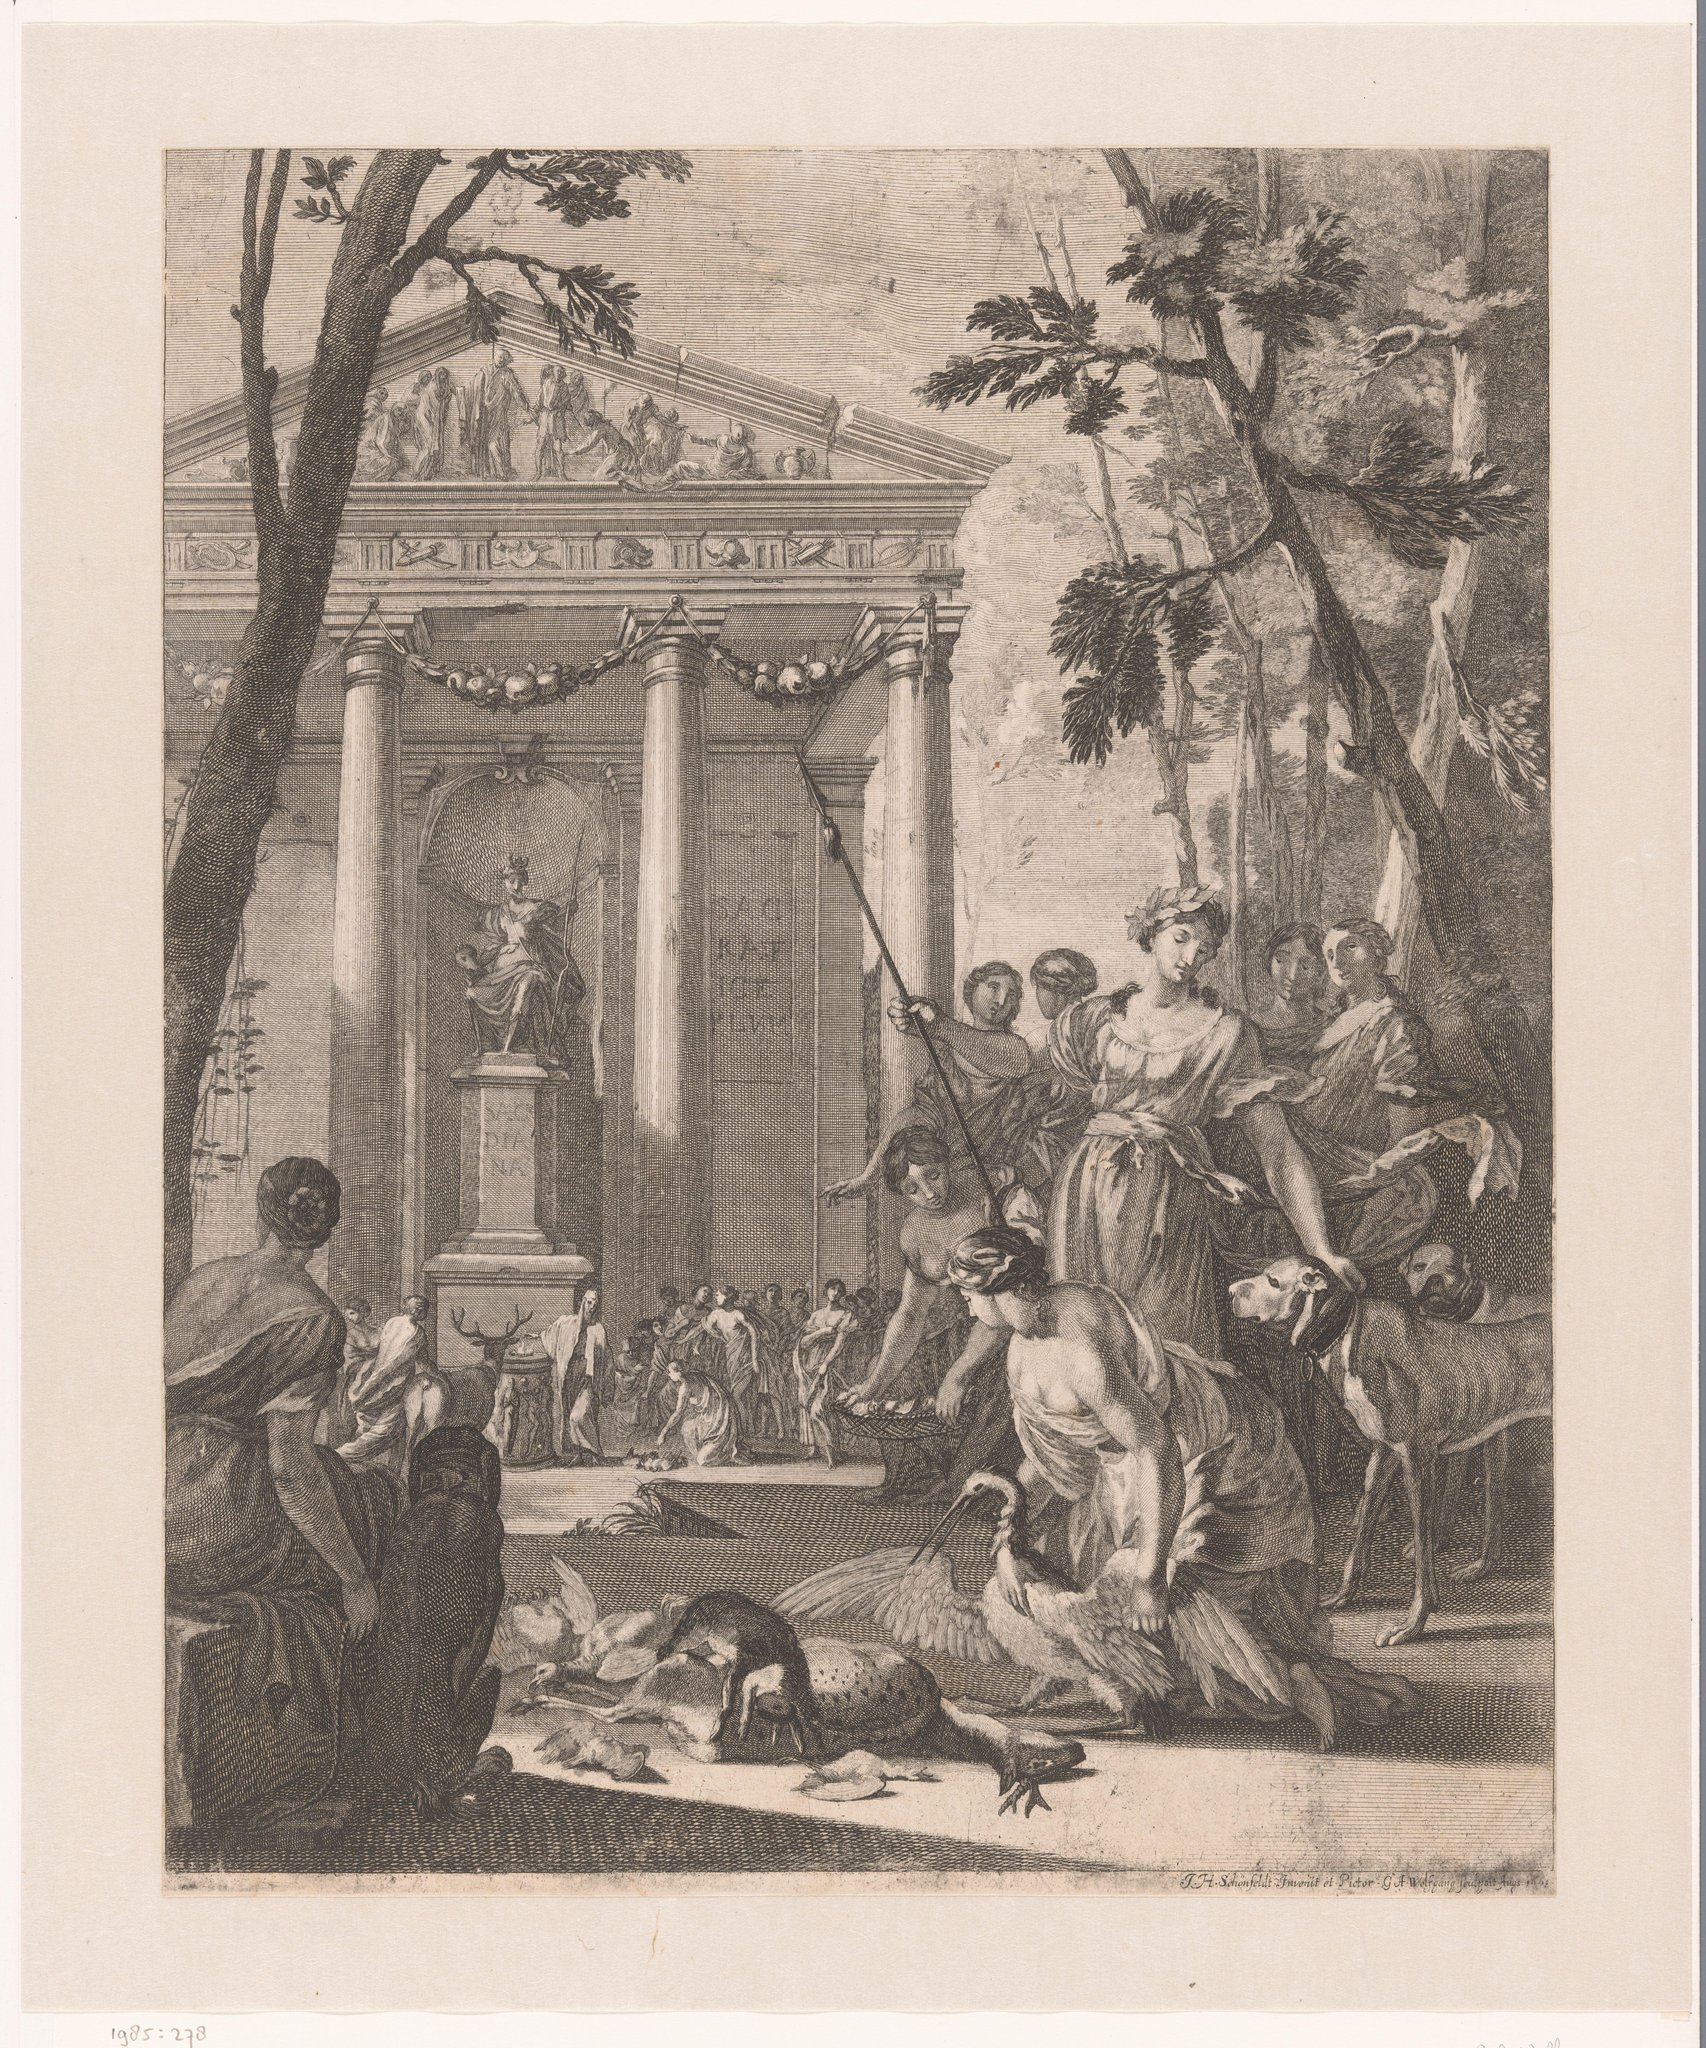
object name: print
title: Offer aan Diana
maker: georg andreas wolfgang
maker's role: goldsmith, print maker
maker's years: 1631-1716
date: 1661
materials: paper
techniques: etching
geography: augsburg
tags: (story of) diana (artemis), hunting dogs, animal sacrifice ~ roman religion, piece of sculpture, reproduction of a piece of sculpture, worship and devotion (in general) ~ roman religion, temple, shrine ~ roman religion, altar ~ roman religion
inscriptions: date